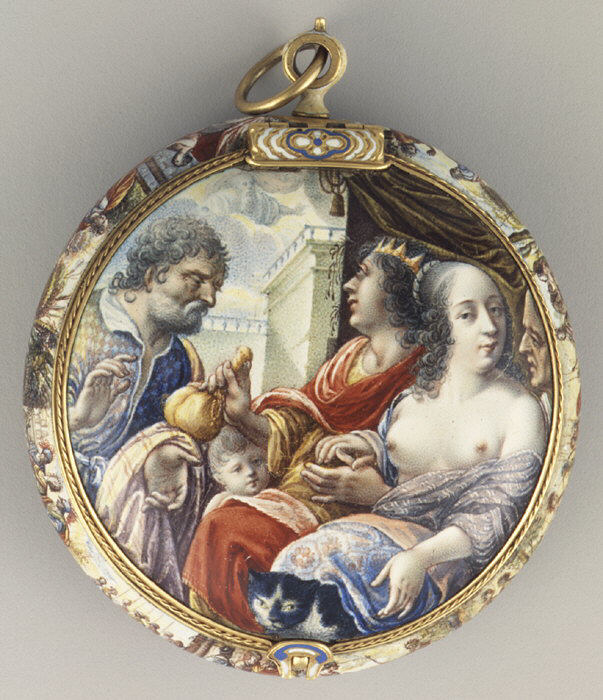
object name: watch case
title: Joseph and Potiphar's Wife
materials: enamel, gold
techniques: painting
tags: children,men,female nudes,cats